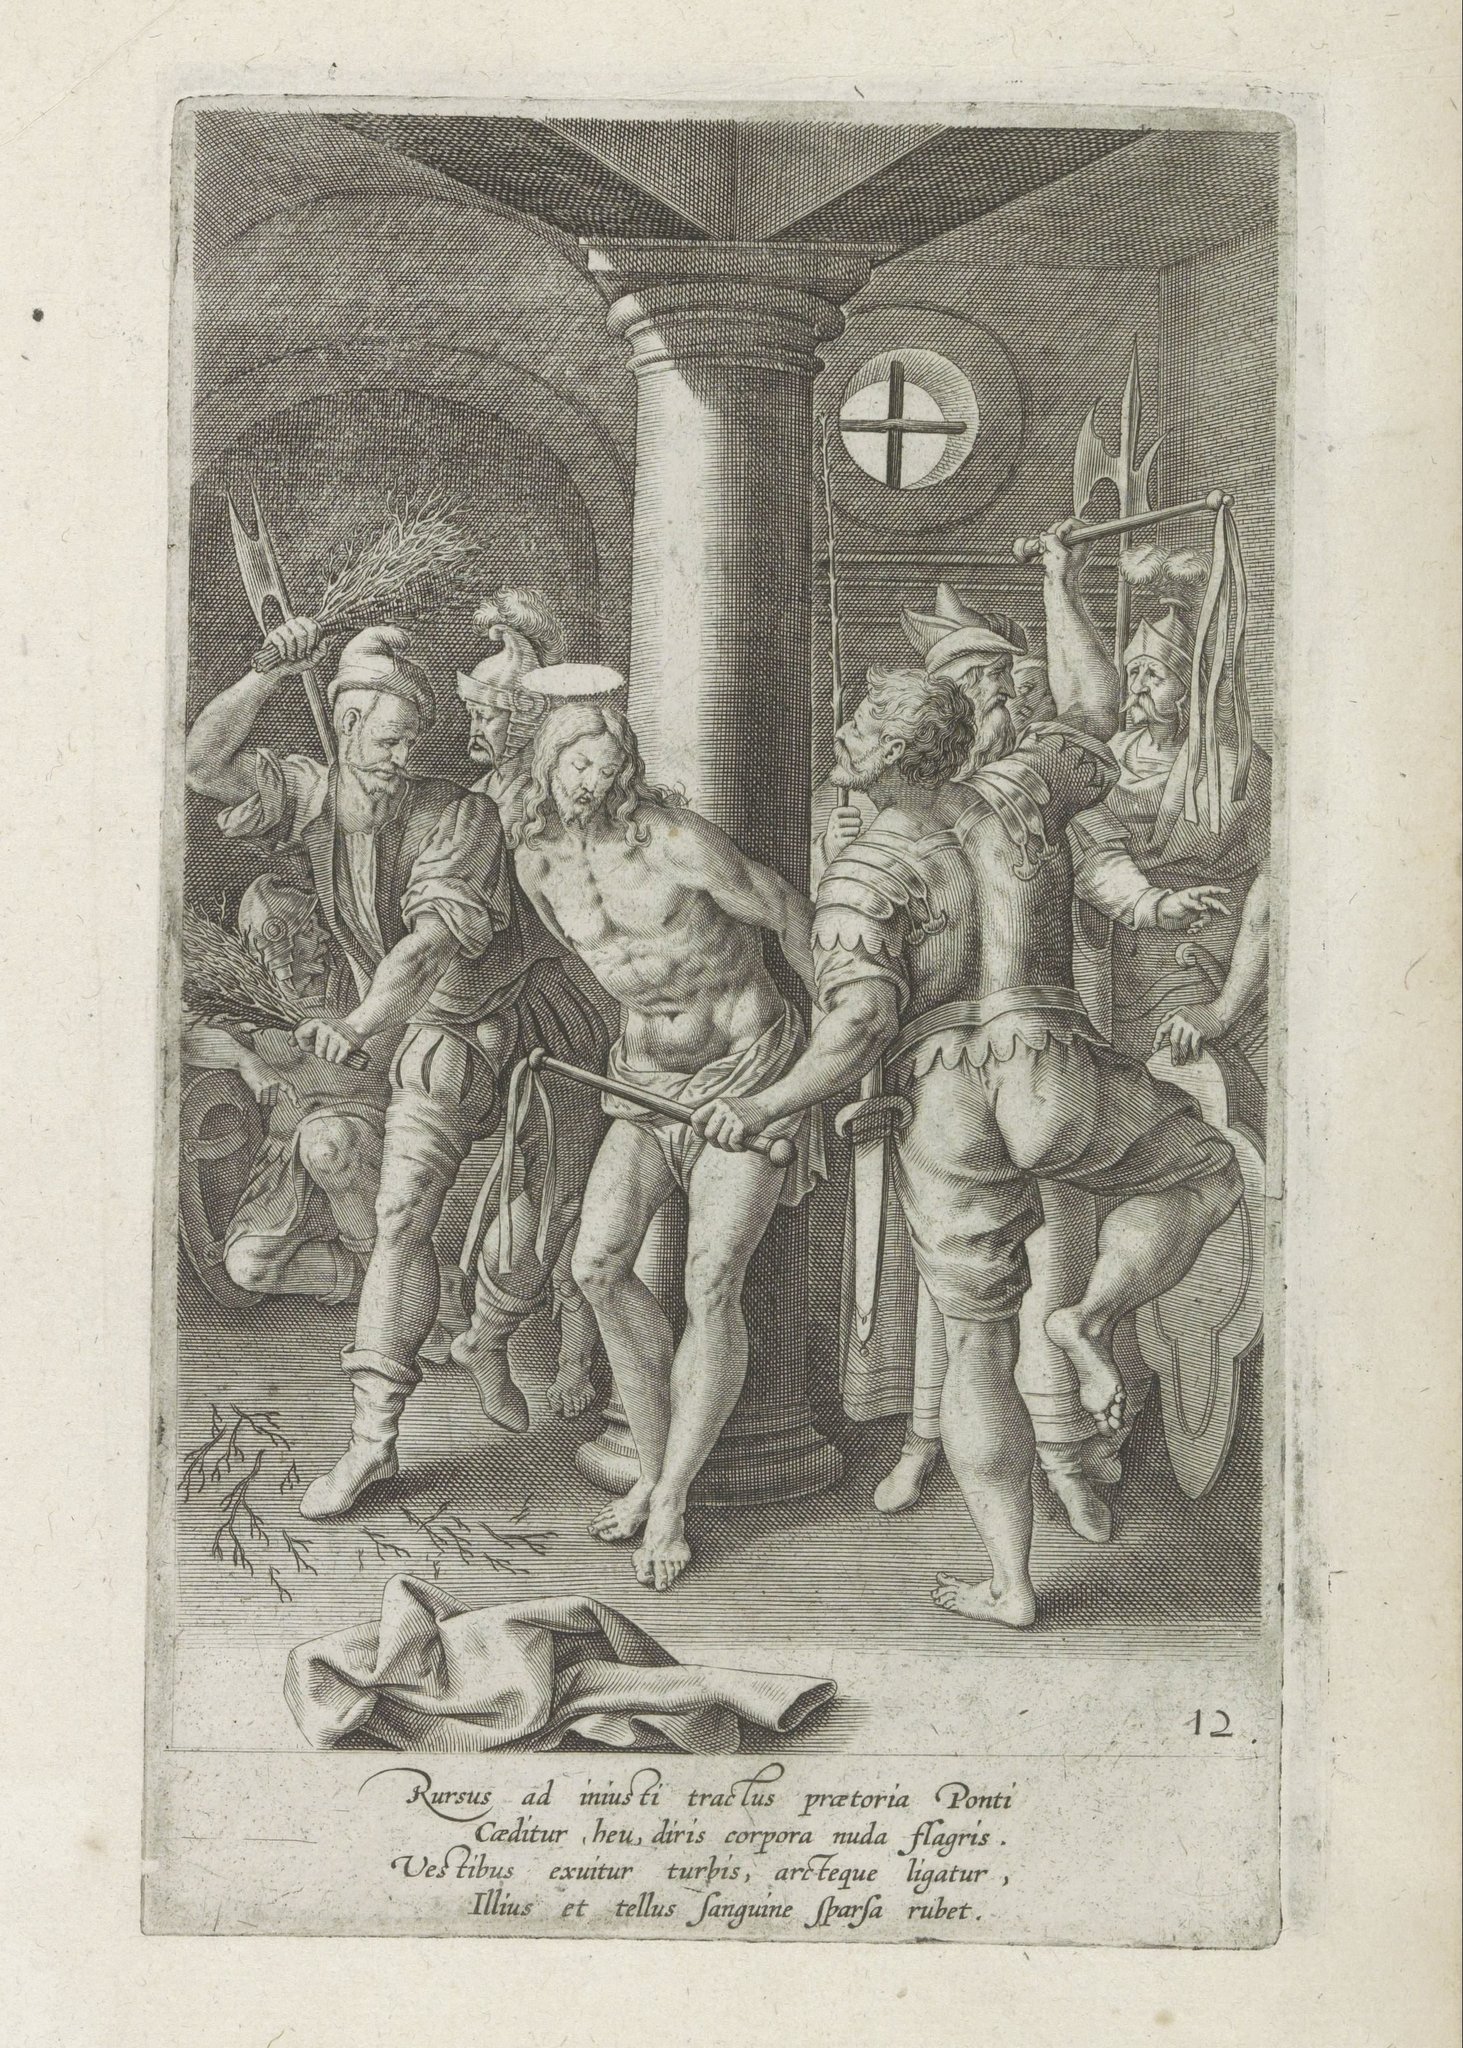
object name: print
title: Thesaurus novi Testamenti elegantissimis iconibus expressus continens historias atque miracula doni nostri Iesu Christi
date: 1585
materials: paper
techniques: engraving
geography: antwerp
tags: flagellation by soldiers, christ usually tied to a column (matthew 27:26; mark 15:15; john 19:1)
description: Christus, gekleed in een lendendoek en vastgebonden aan een pilaar, wordt door soldaten geschopt en gegeseld. Onder de voorstelling een vierregelig vers in het Latijn. Deze prent maakt deel uit van een album.